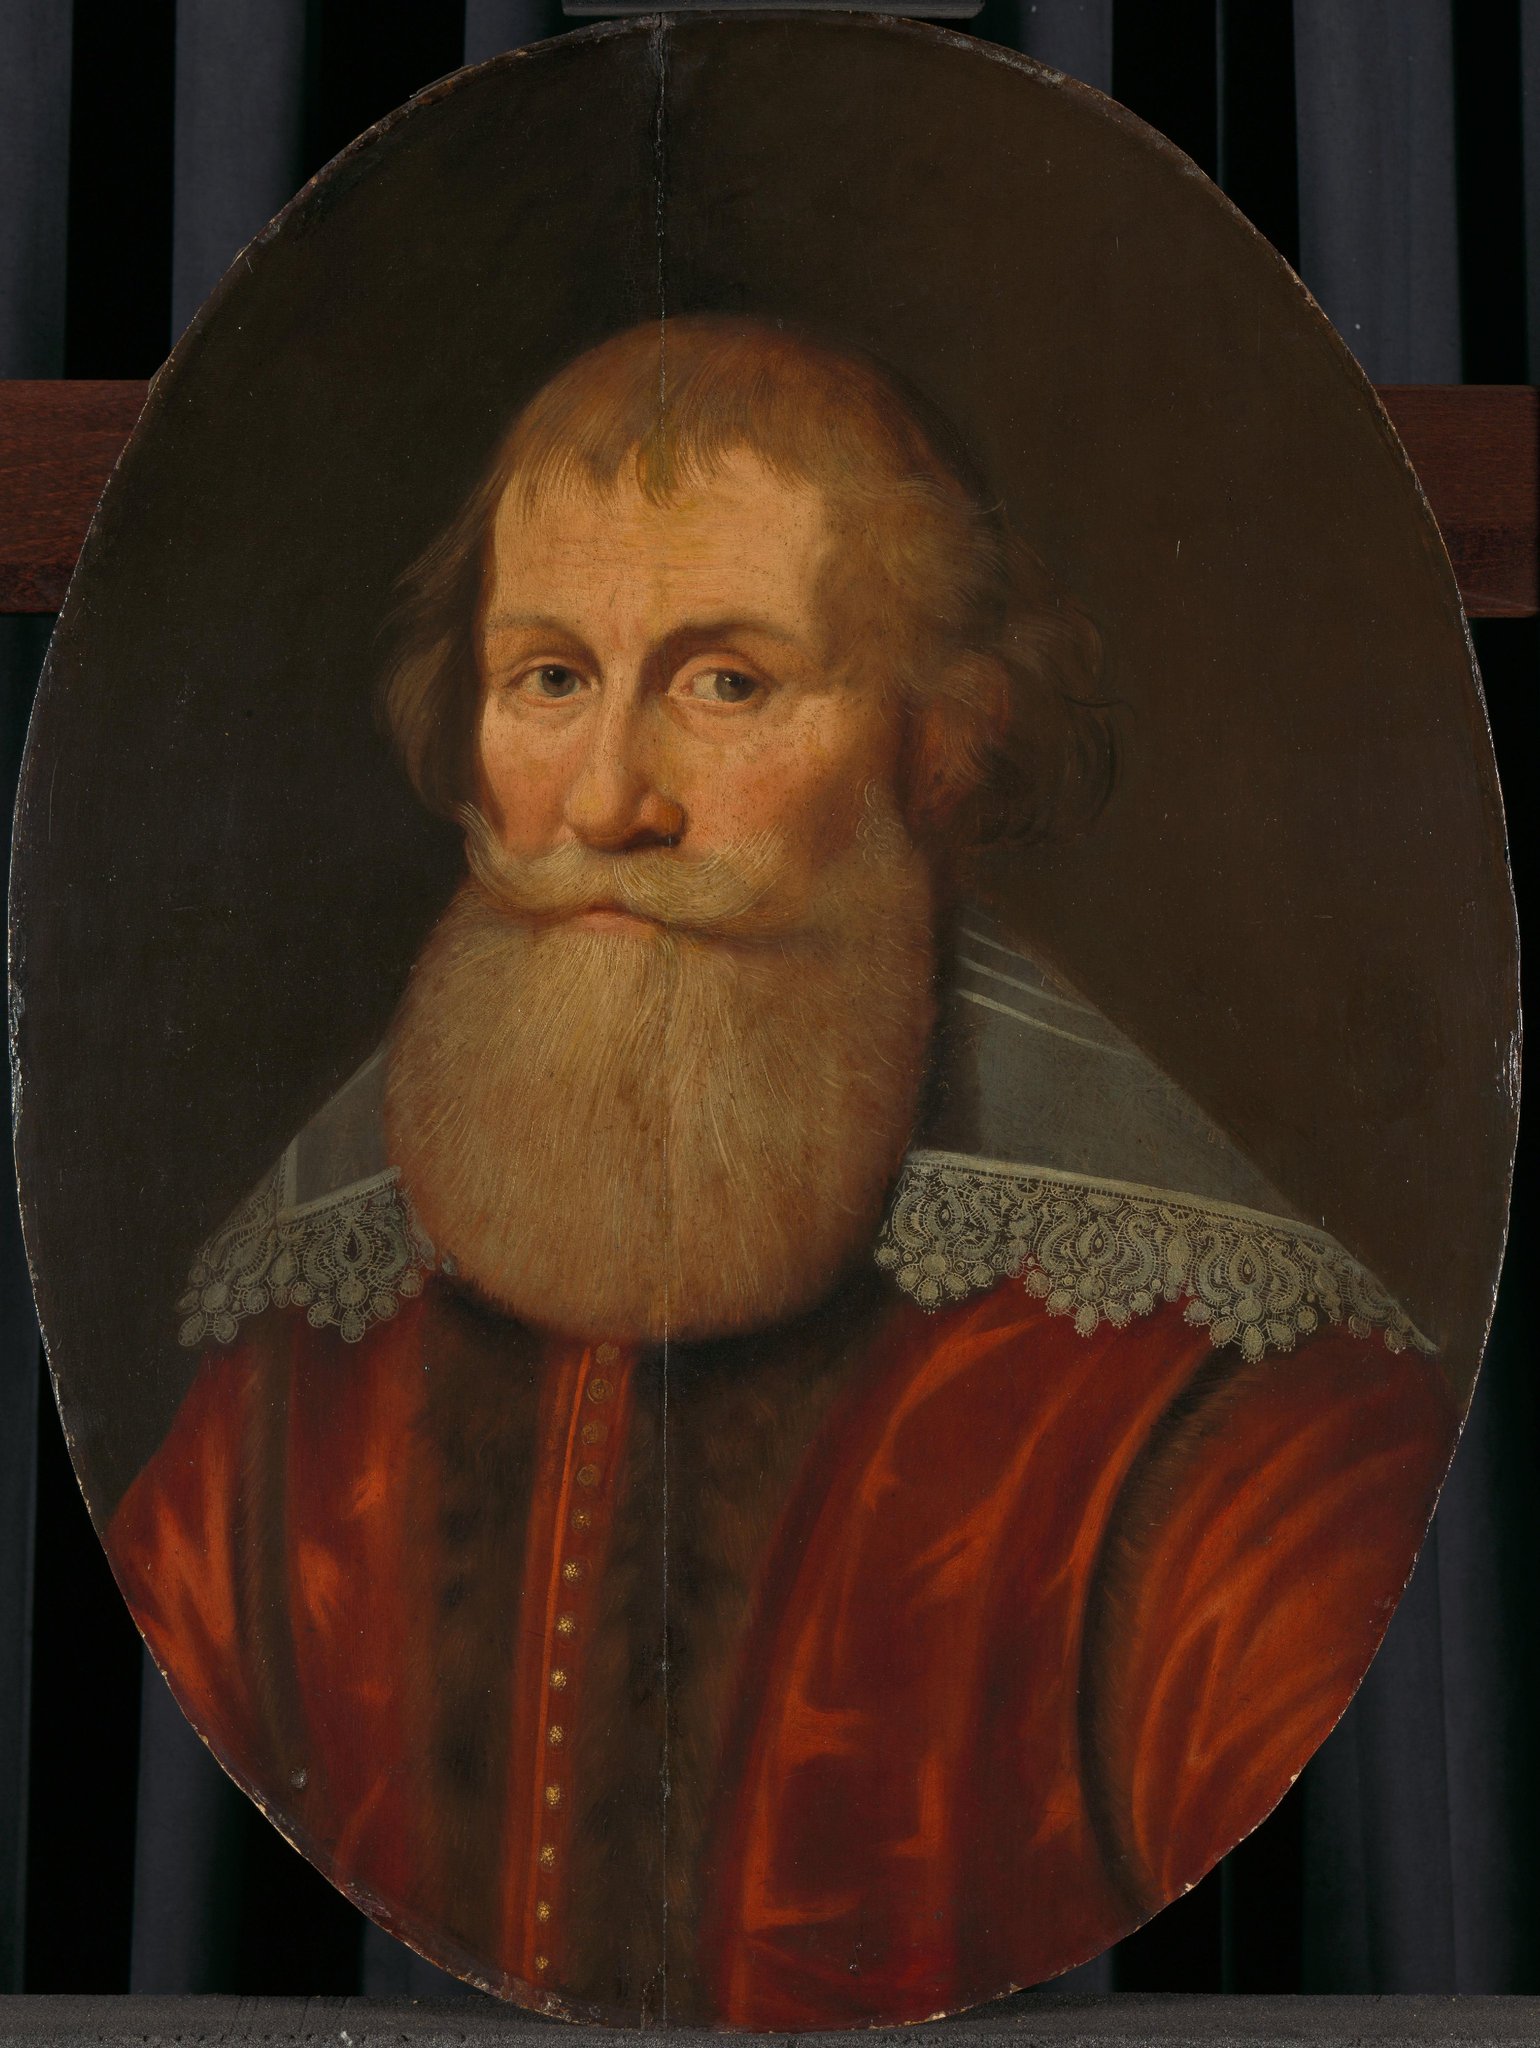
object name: painting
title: Portrait of Cornelis Haga (1578-1654)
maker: Anonymous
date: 1645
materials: oil, panel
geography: northern netherlands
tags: historical persons, ambassador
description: Portret van Cornelis Haga (1578-1654). Nederlands gezant bij het Turkse hof. Buste in ovaal naar links.